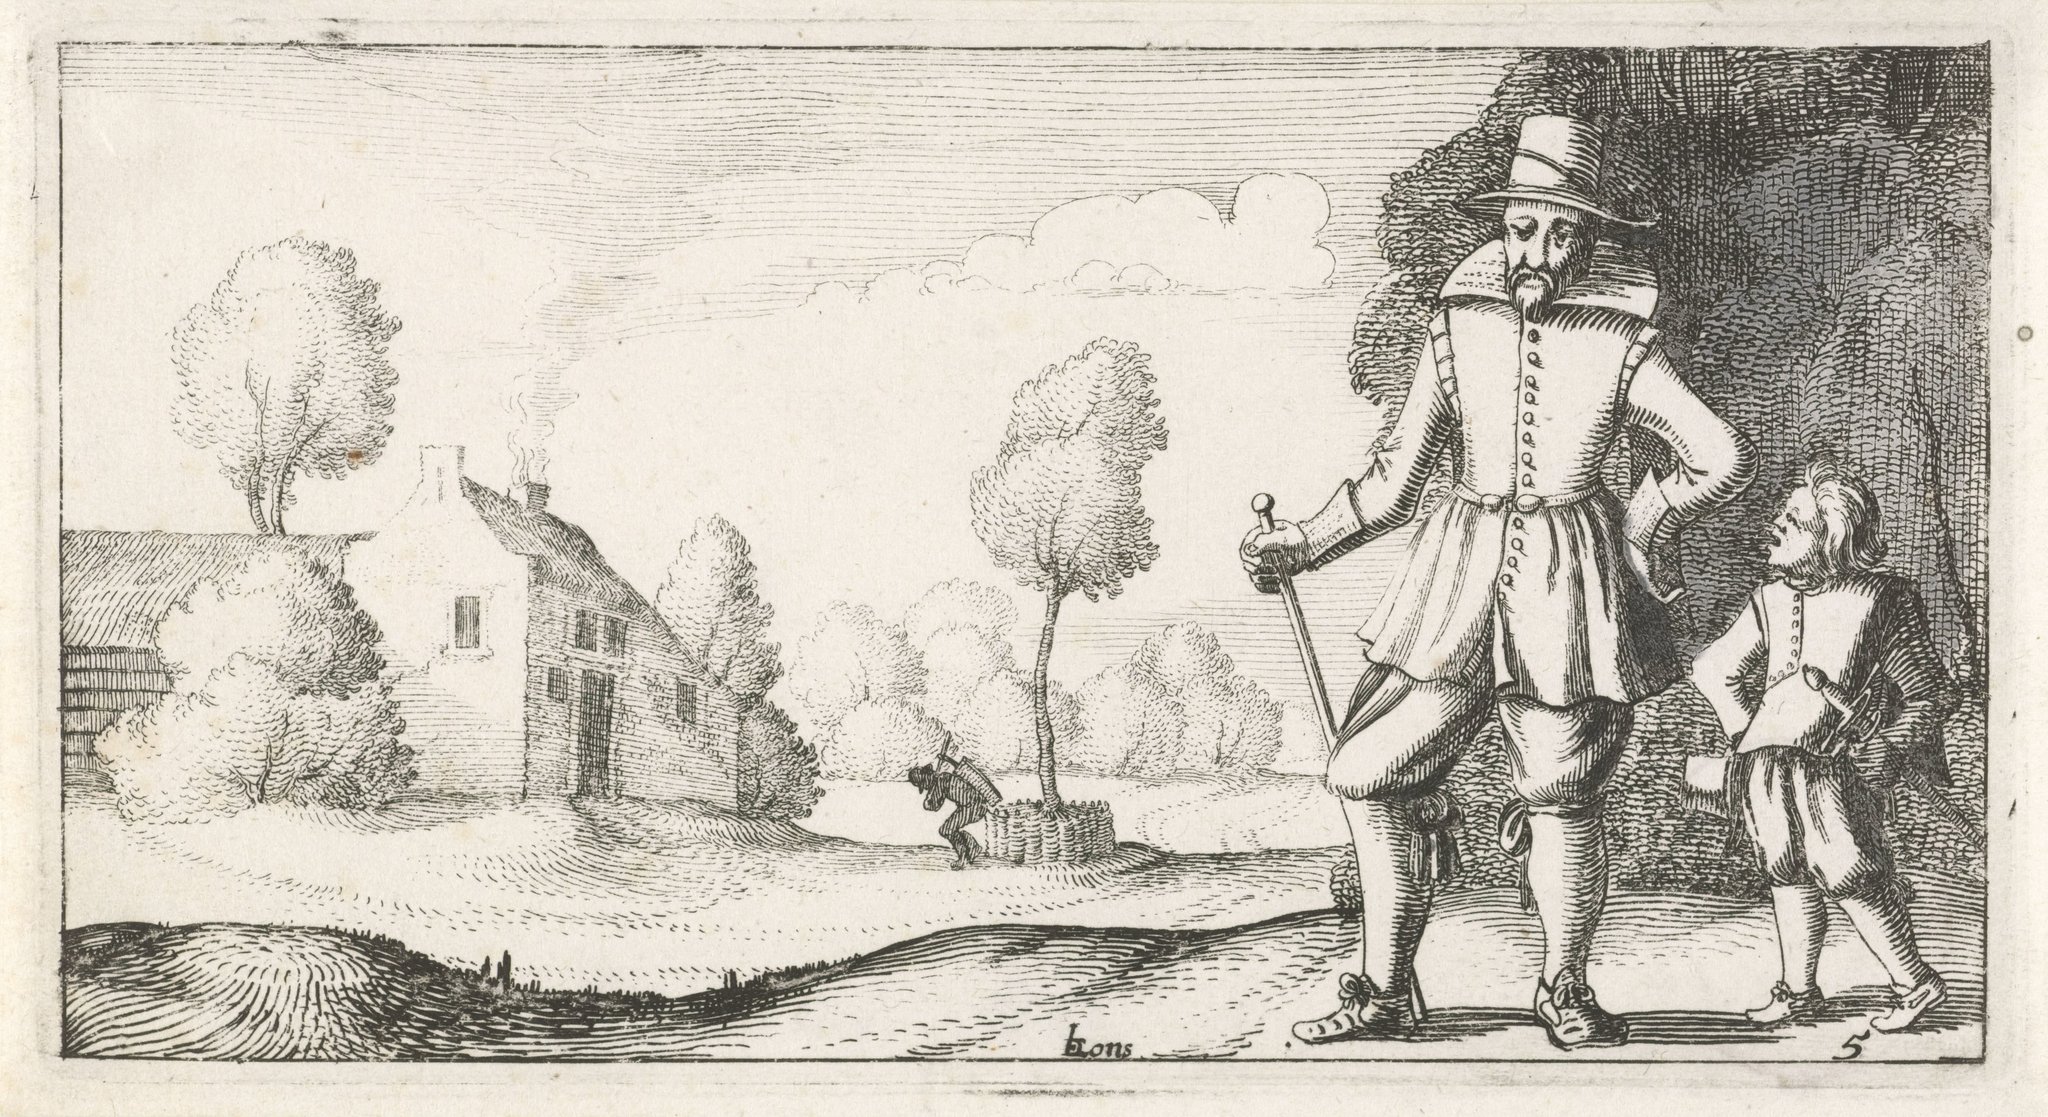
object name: costume print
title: Nederlandse vrouwen- en mannenkostuums, 1622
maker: dirk eversen lons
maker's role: print maker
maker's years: 1599-1686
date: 1622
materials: paper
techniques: brush, engraving, etching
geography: amsterdam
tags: fashion, clothing (+ boys' clothes), clothes, costume (+ men's clothes), country-house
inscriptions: collector's mark: Lugt 240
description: Een man met wandelstok in de hand en een jongen met zwaard om het middel staande naast elkaar in een landschap. Op de achtergrond een boerenwoning met schuur.